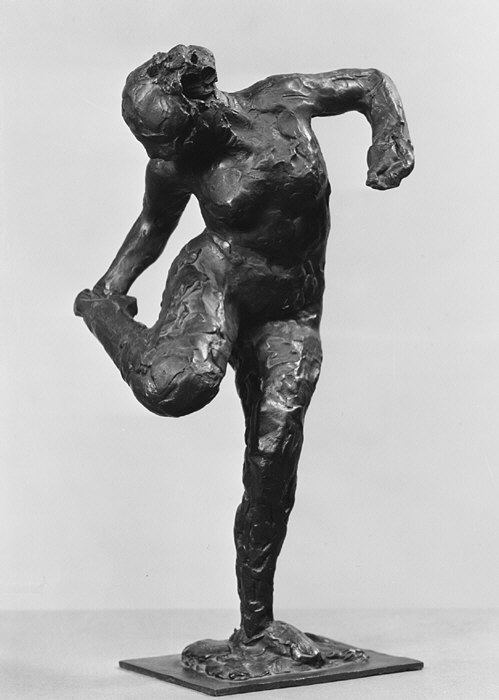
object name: statuette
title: Dancer Looking at the Sole of Her Right Foot (Second State)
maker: edgar degas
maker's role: artist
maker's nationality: french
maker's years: 1834-1917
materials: bronze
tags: feet,women,dancers